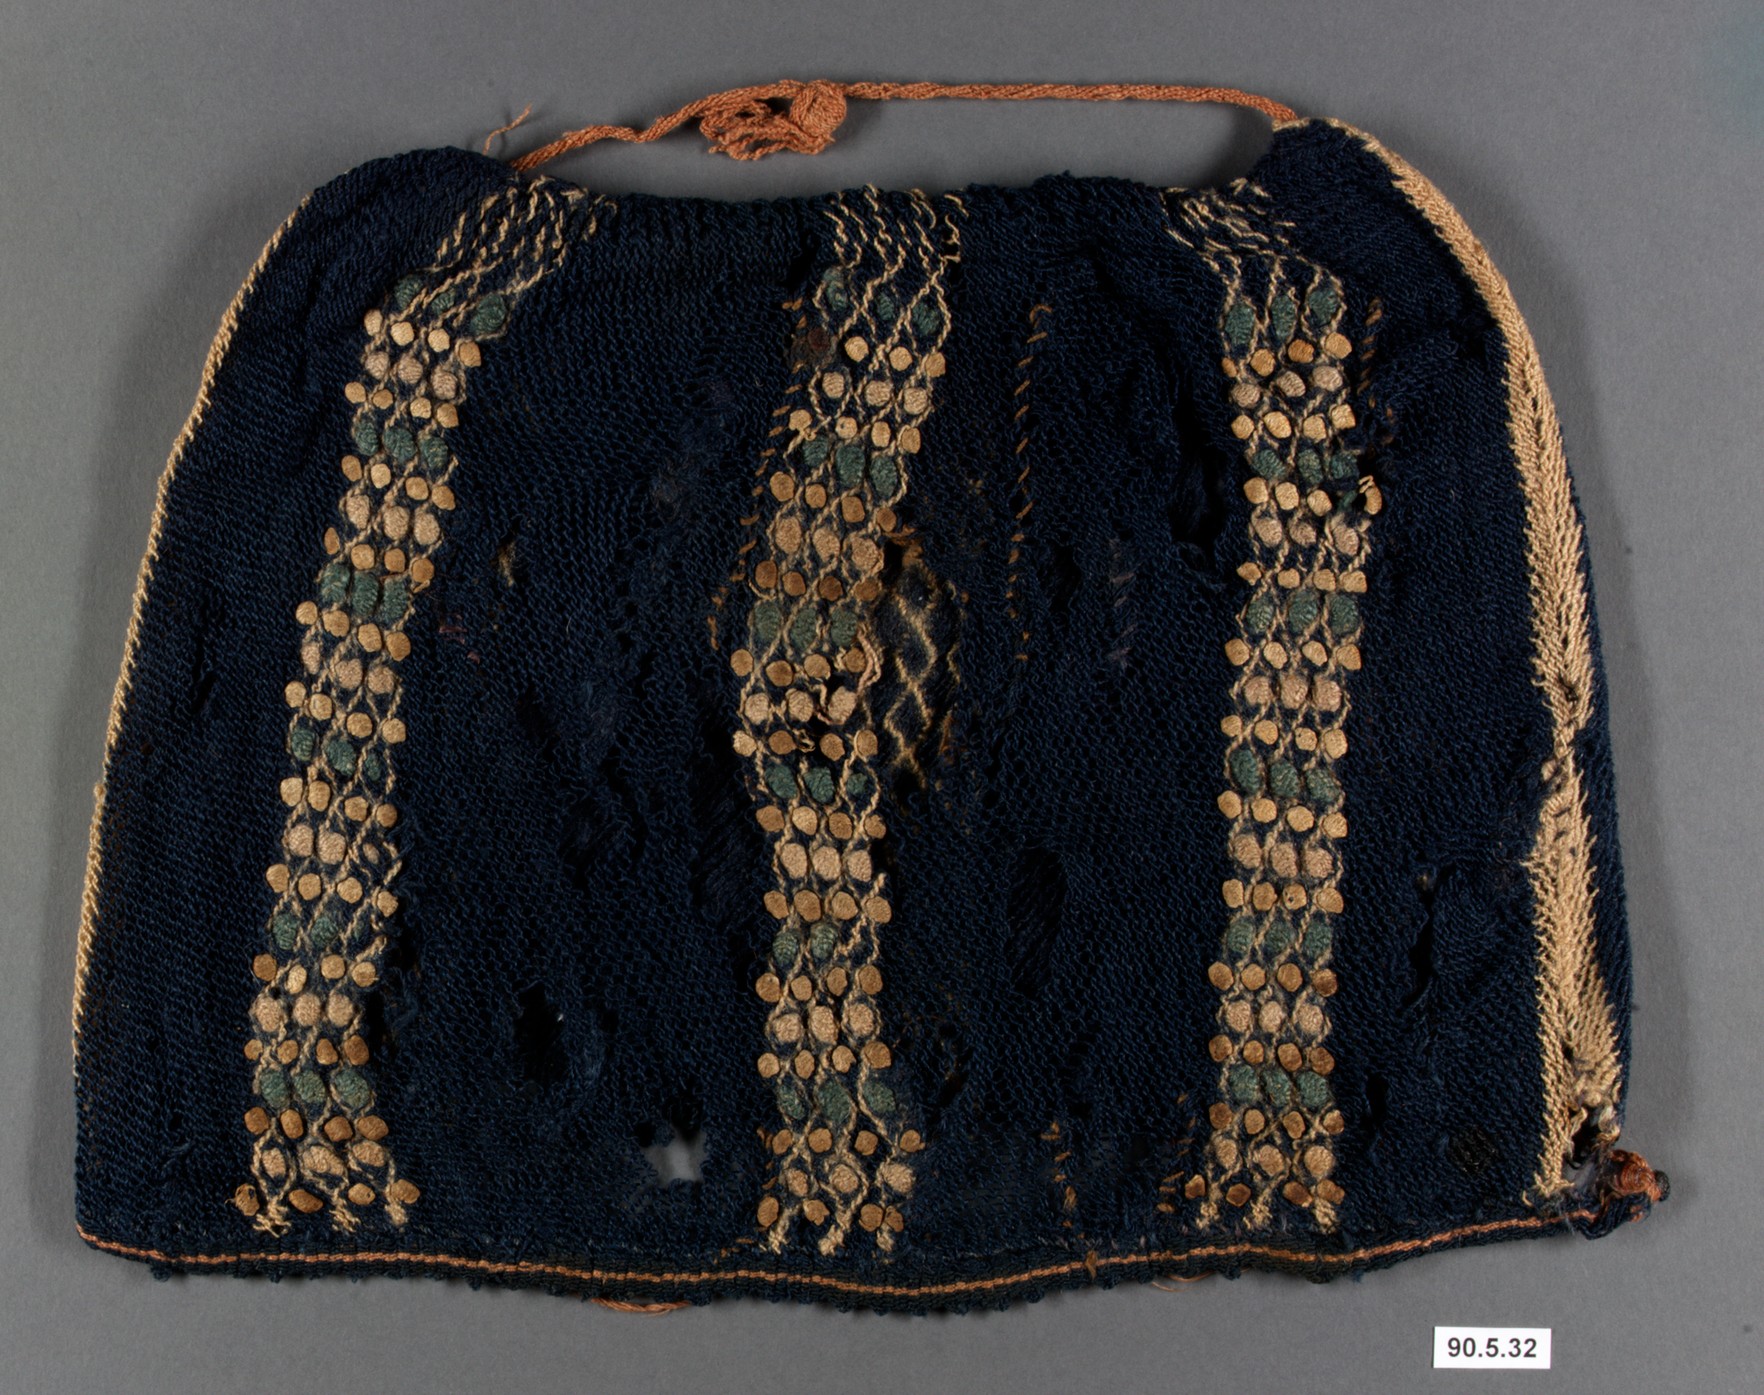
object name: hat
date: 401-900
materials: wool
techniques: embroidery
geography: egypt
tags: hats